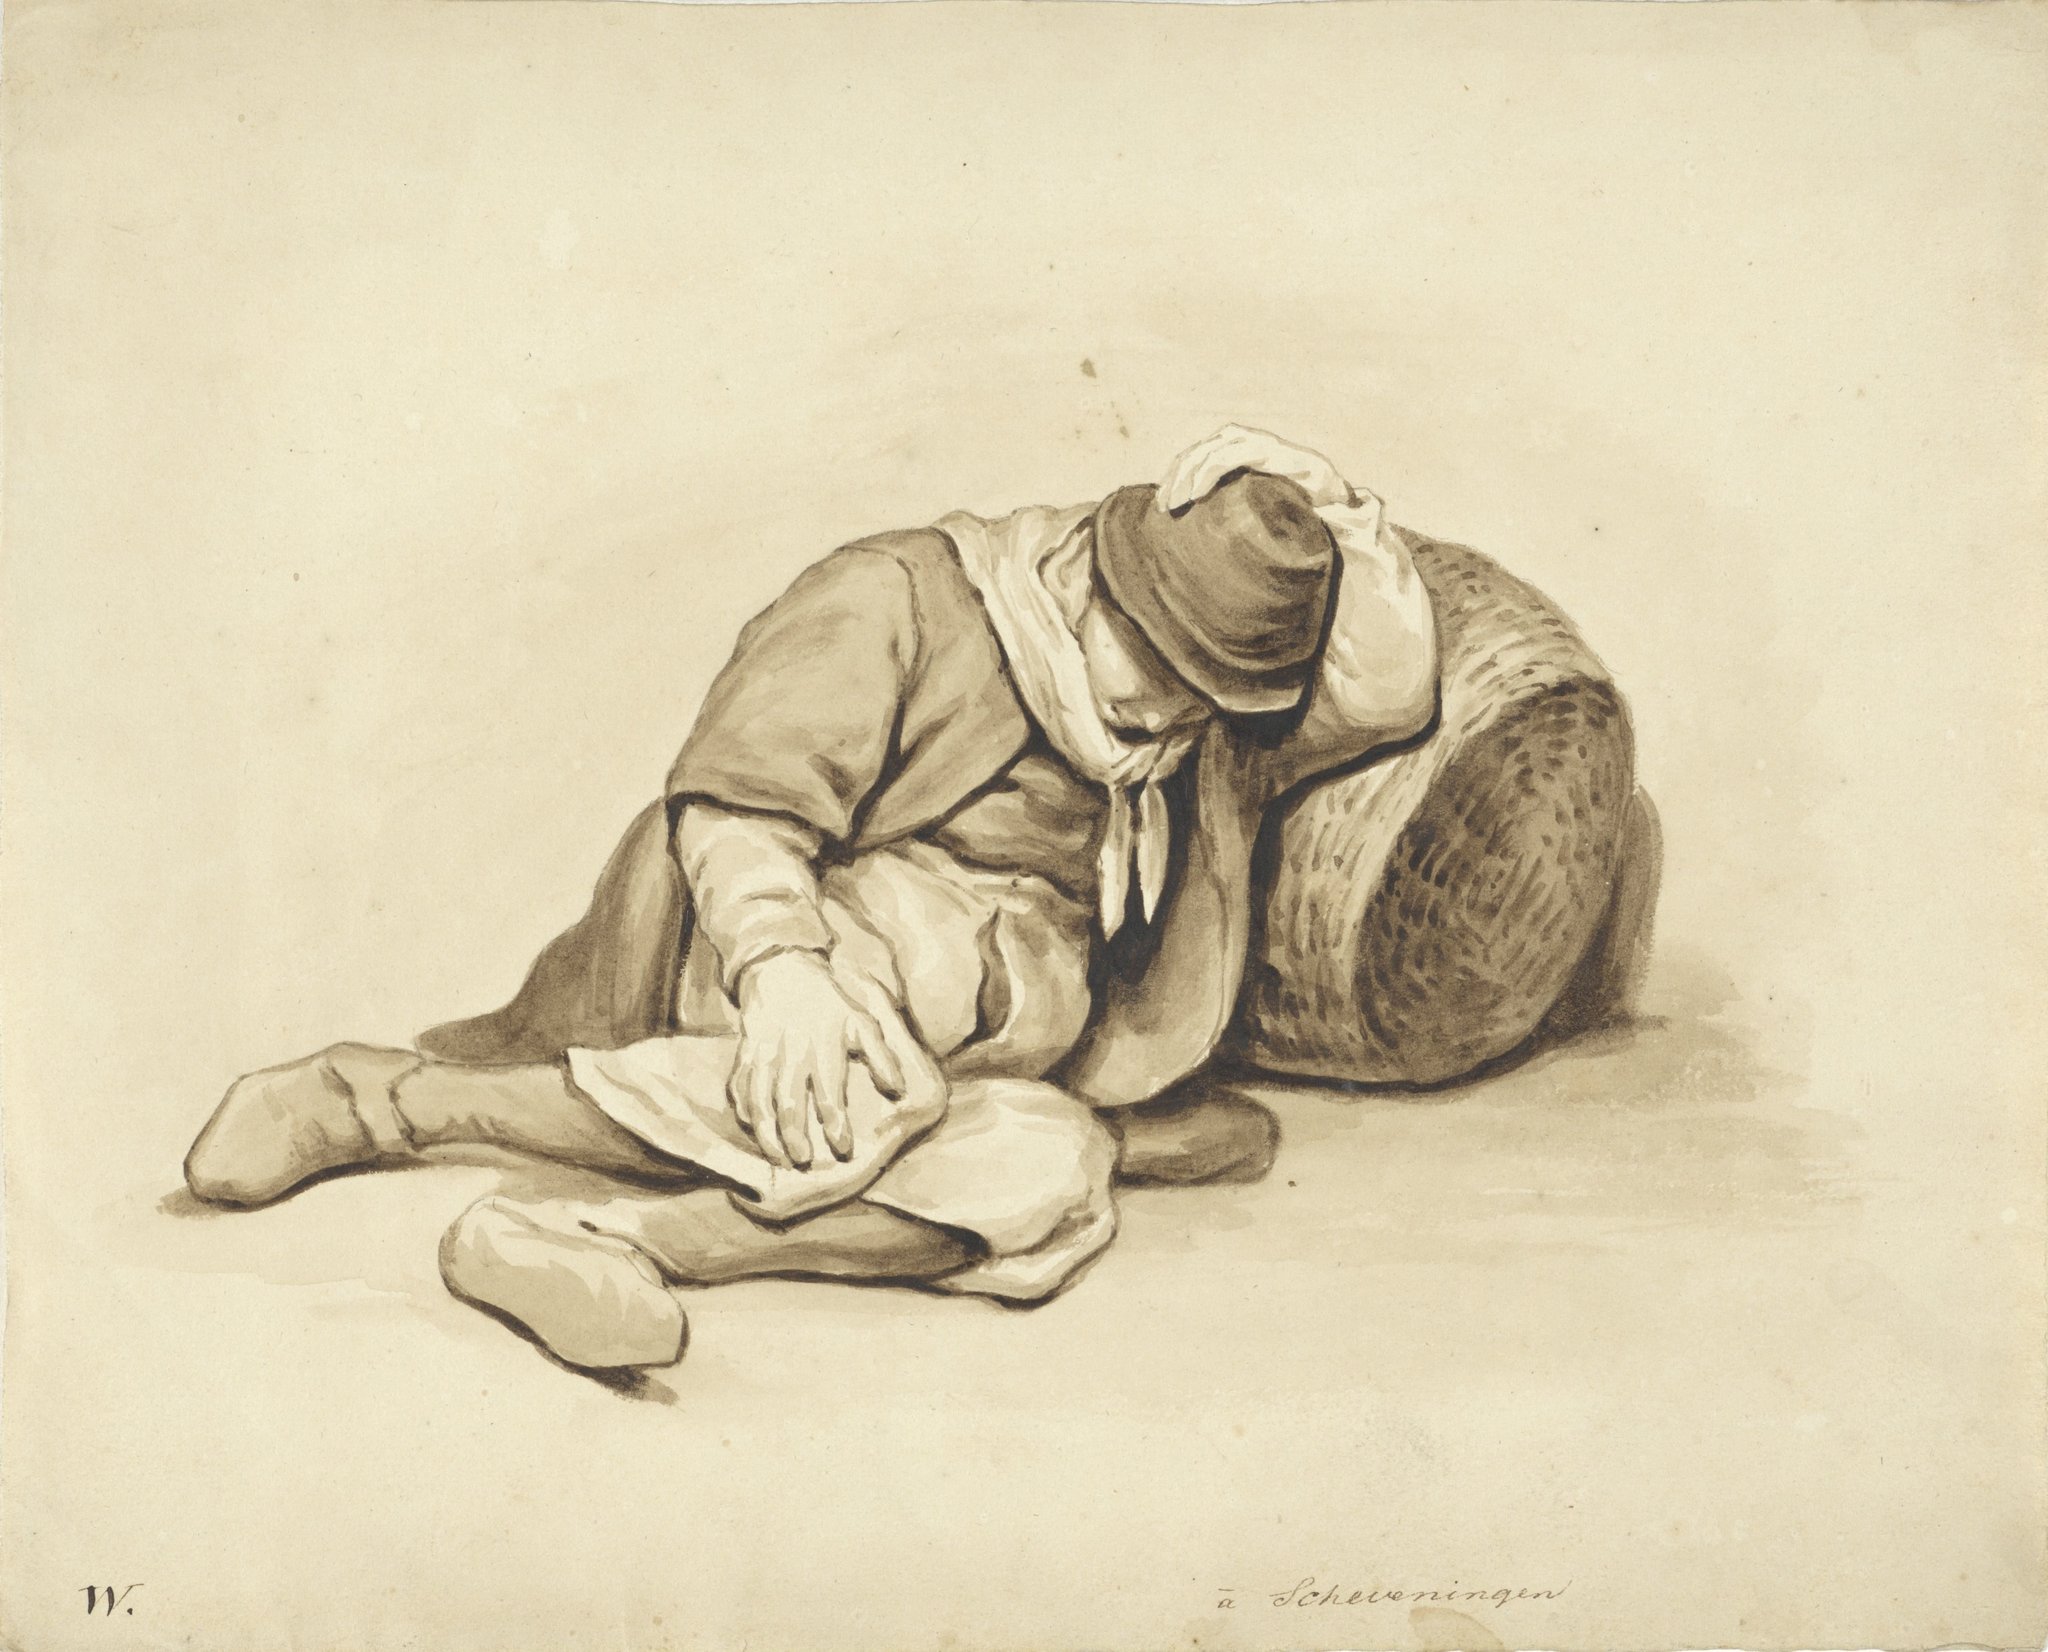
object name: drawing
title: Jongen slapend tegen een vismand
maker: pieter van loon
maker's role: draughtsman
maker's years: 1801-1873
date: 1811-1873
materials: paper, pencil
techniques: brush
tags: folk costume, regional costume, fisherman